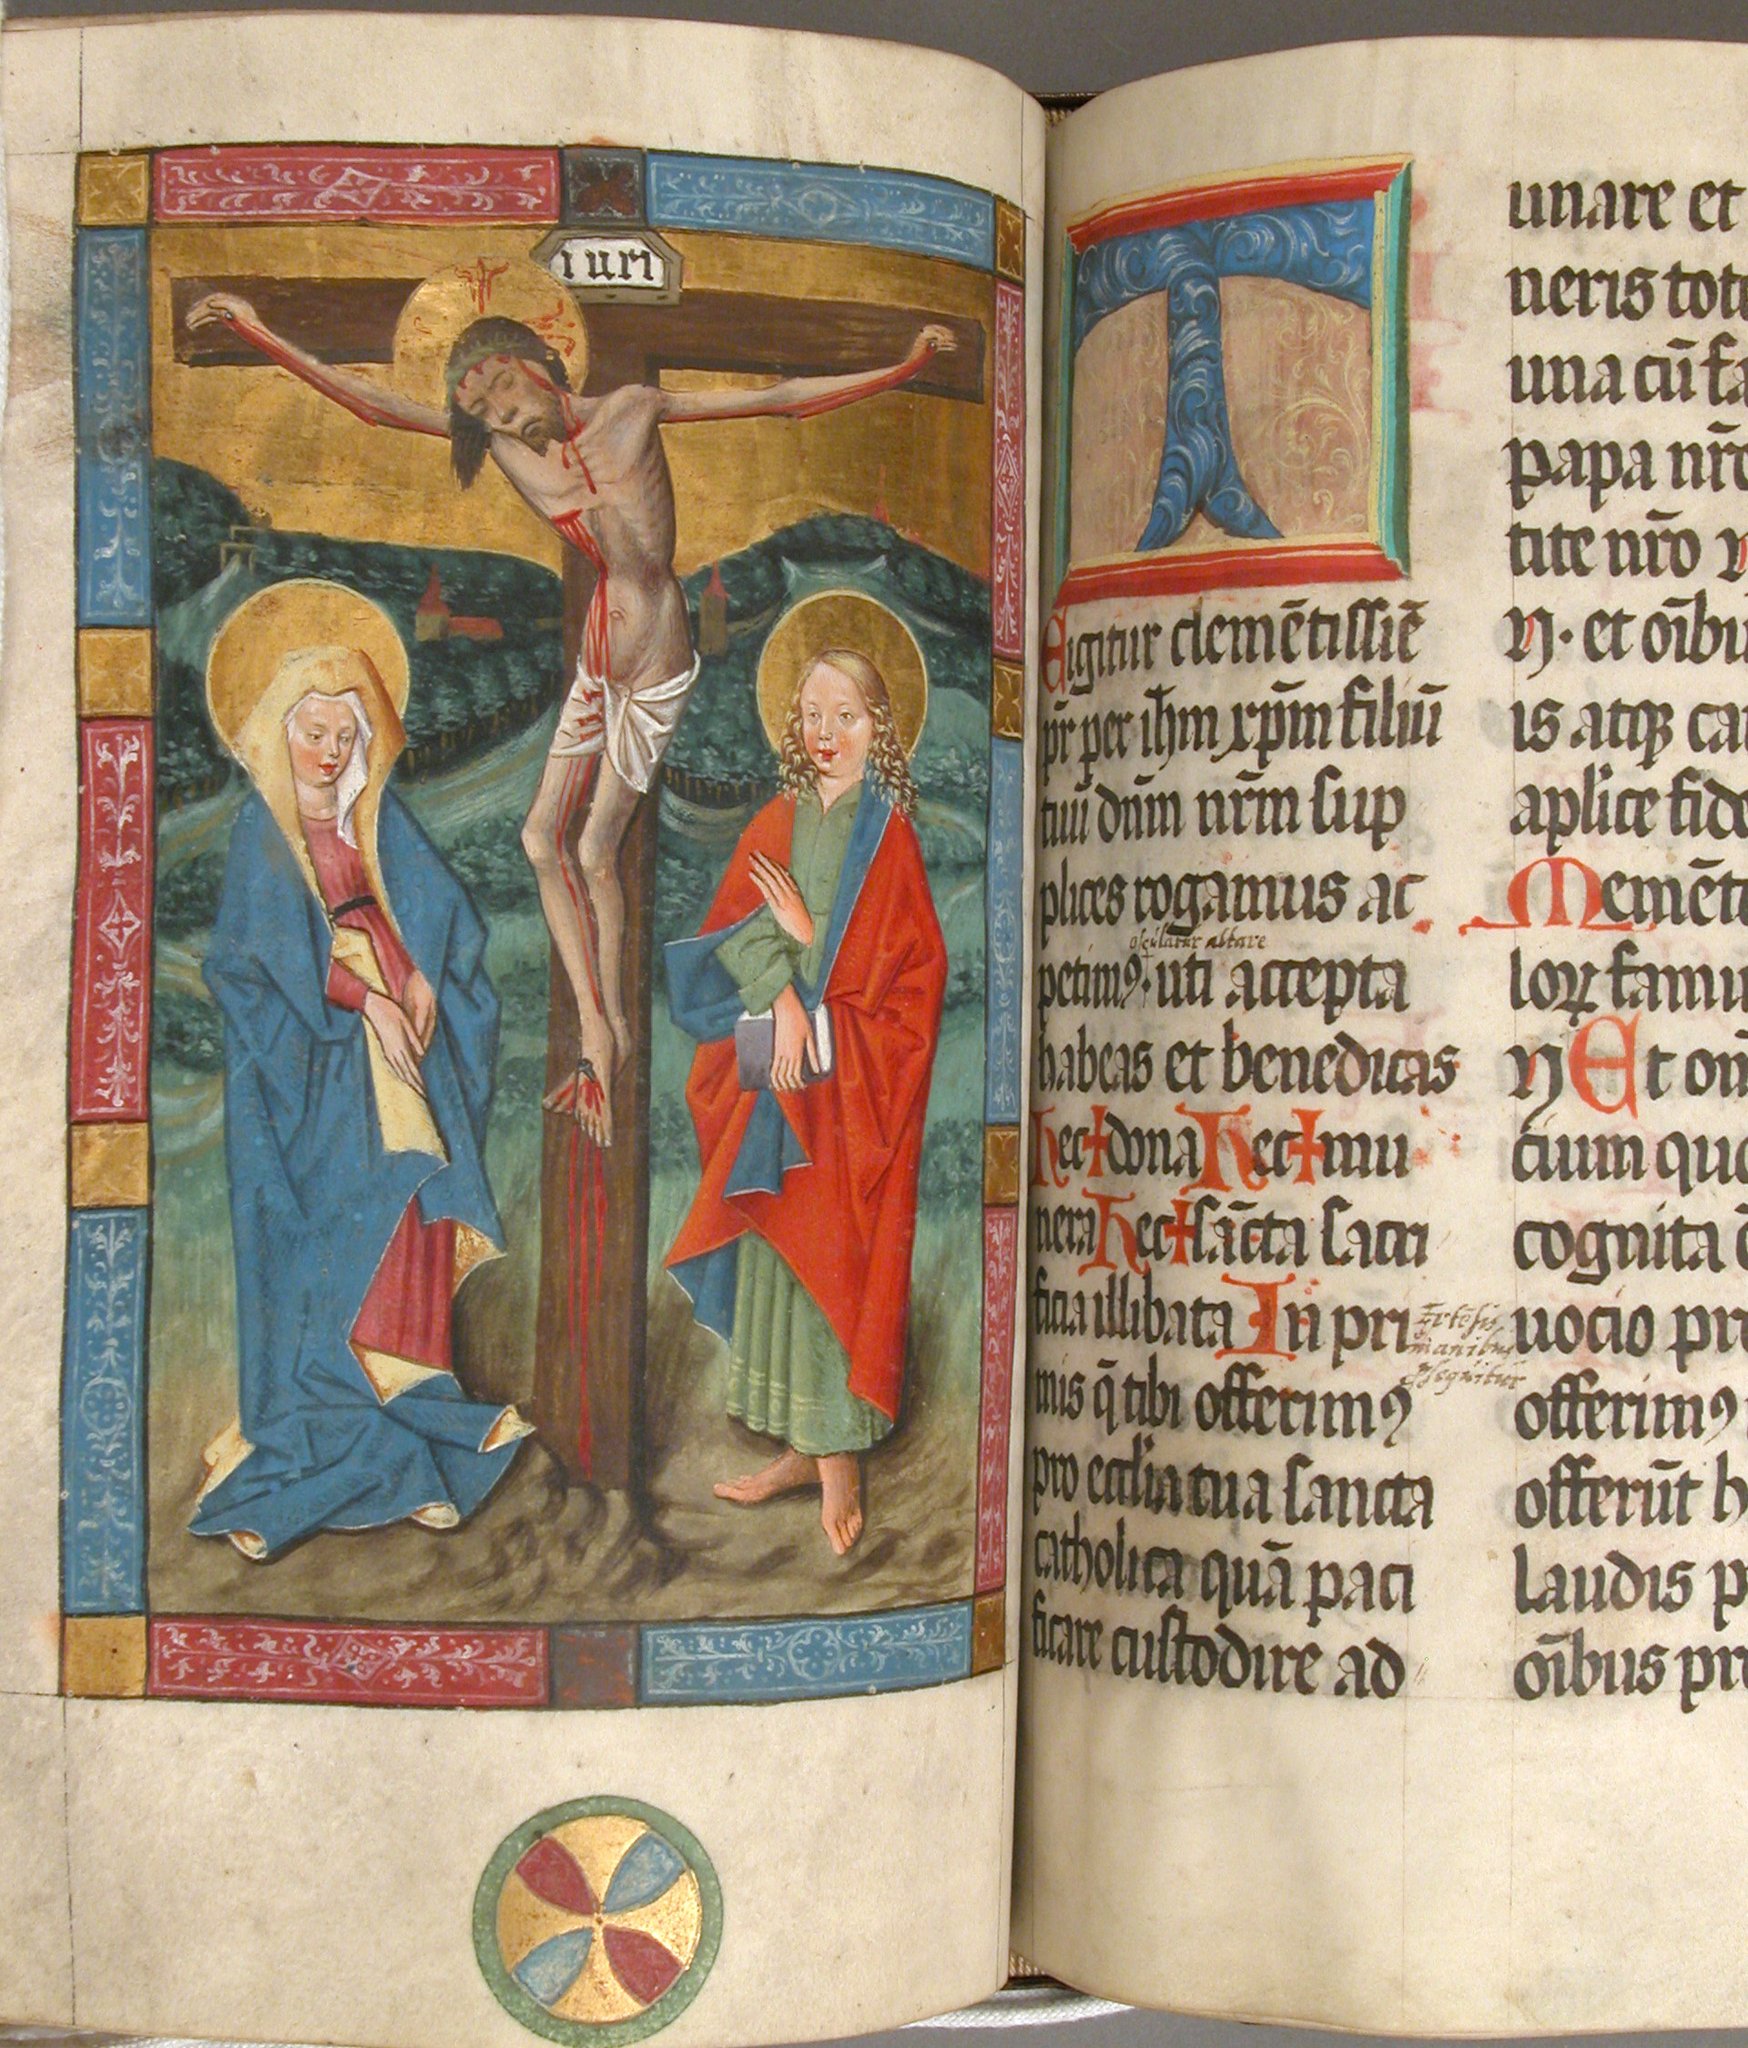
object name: missal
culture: german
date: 1472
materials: ink, leather, metal leaf, parchment, paint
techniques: bookbinding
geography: germany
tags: christ,crucifixion